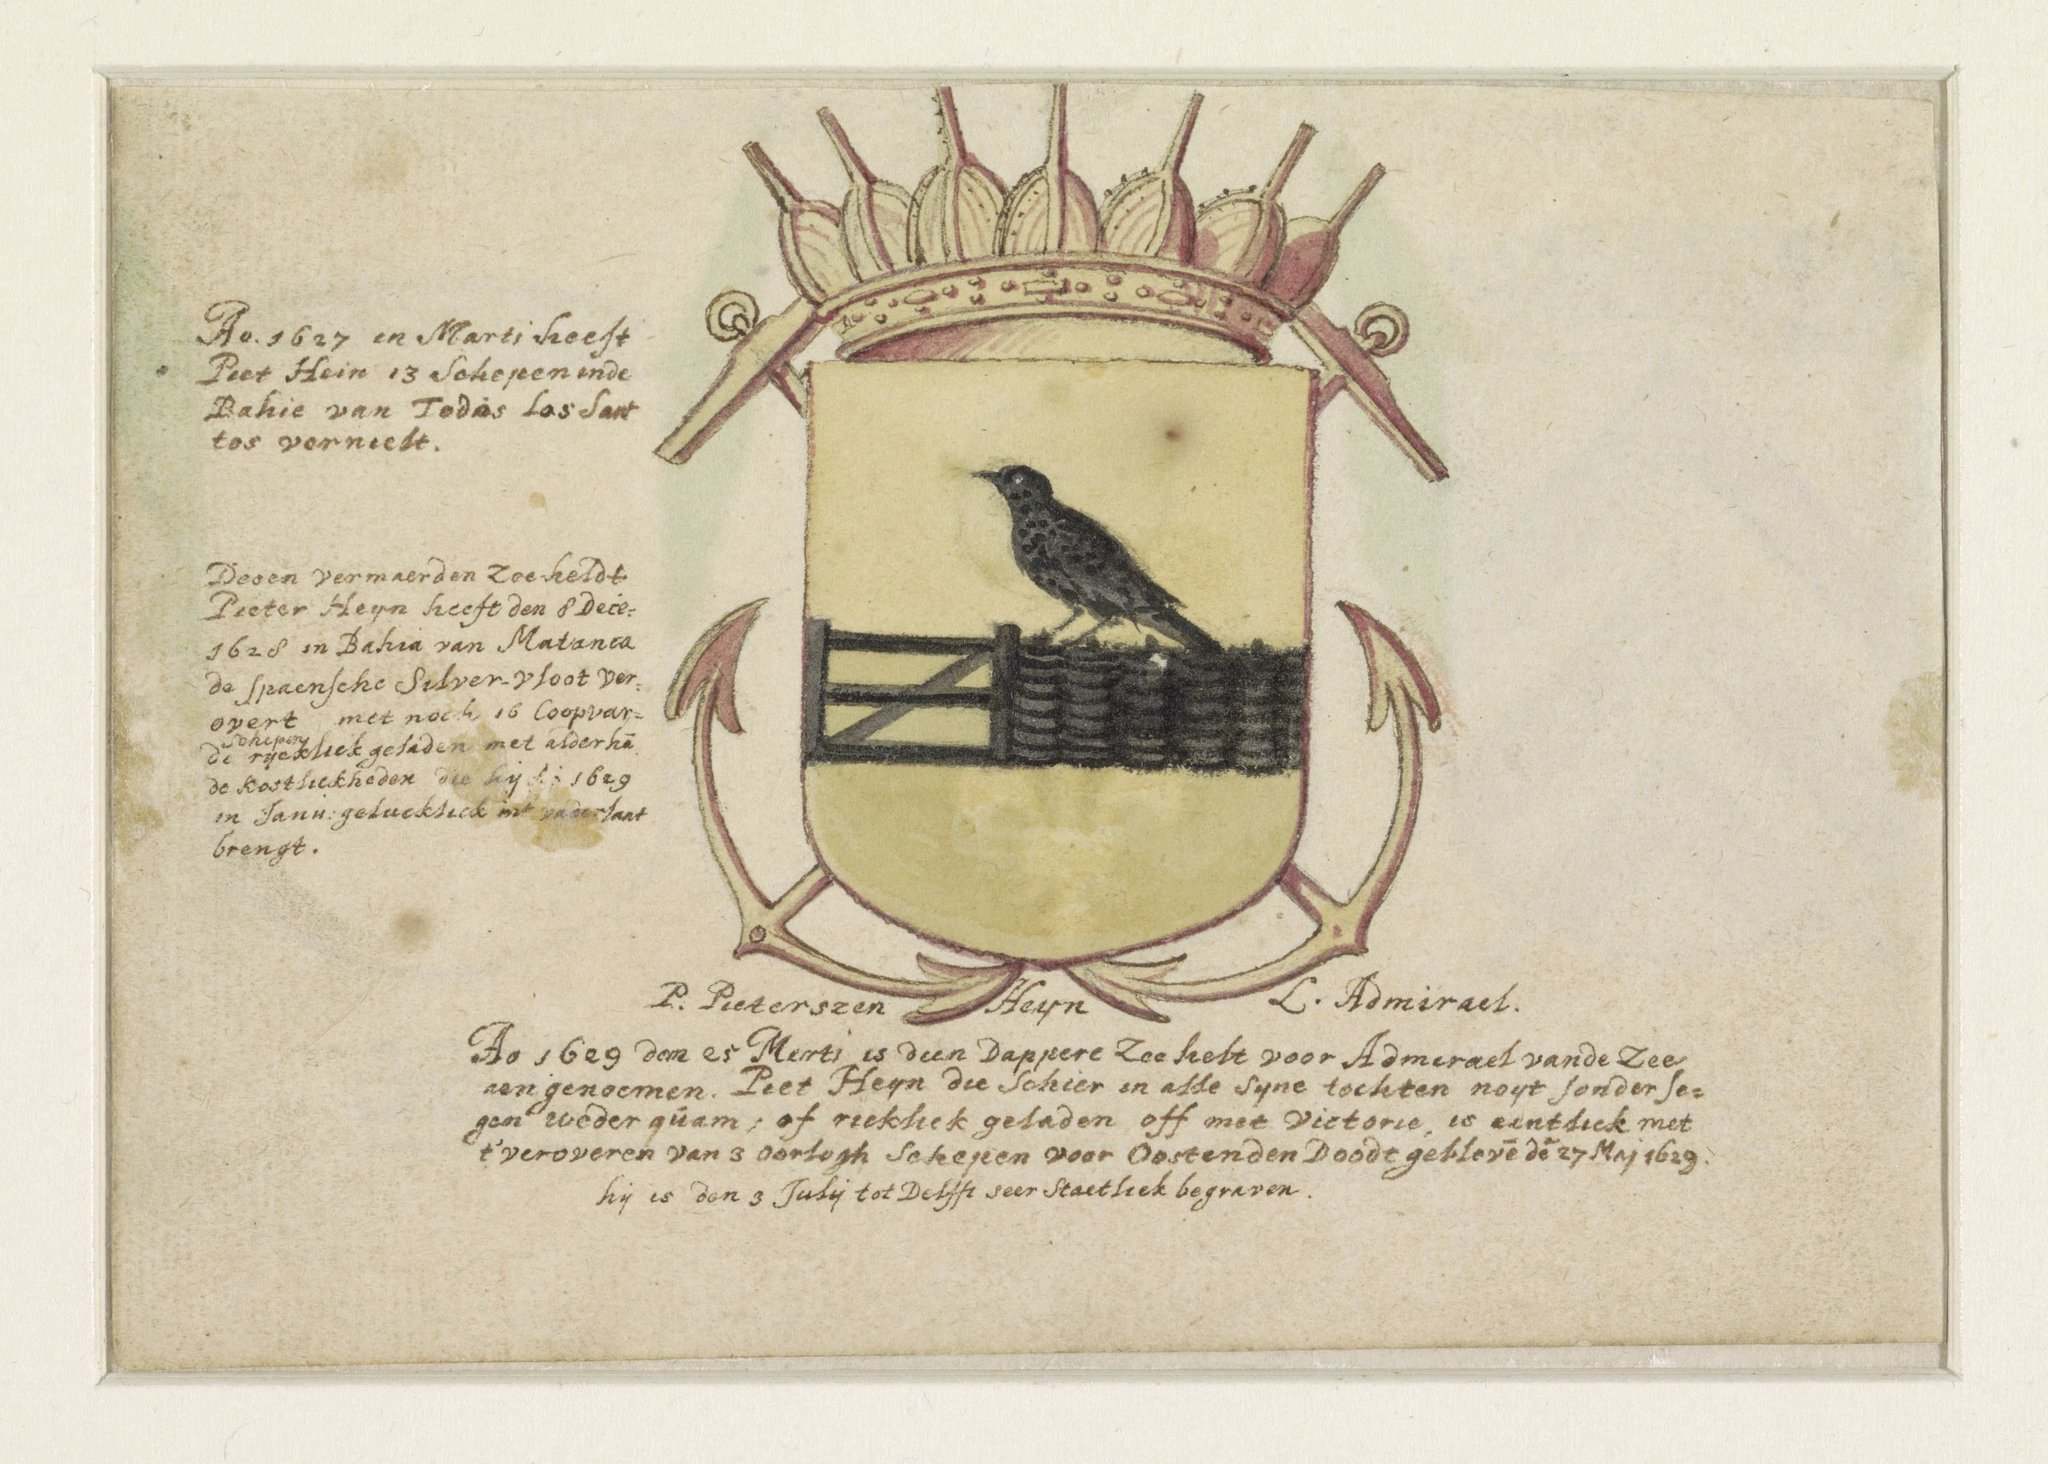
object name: drawing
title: Wapen van Van Dorth en van admiraal Jacob Willekens en een leeg wapenschild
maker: Anonymous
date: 1623-1699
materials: chalk, ink, paper, watercolor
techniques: brush, pen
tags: armorial bearing, heraldry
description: Met onder de wapenschilden handgeschreven tekst over het vertrek van een vloot in 1623 richting Zuid-Amerika.